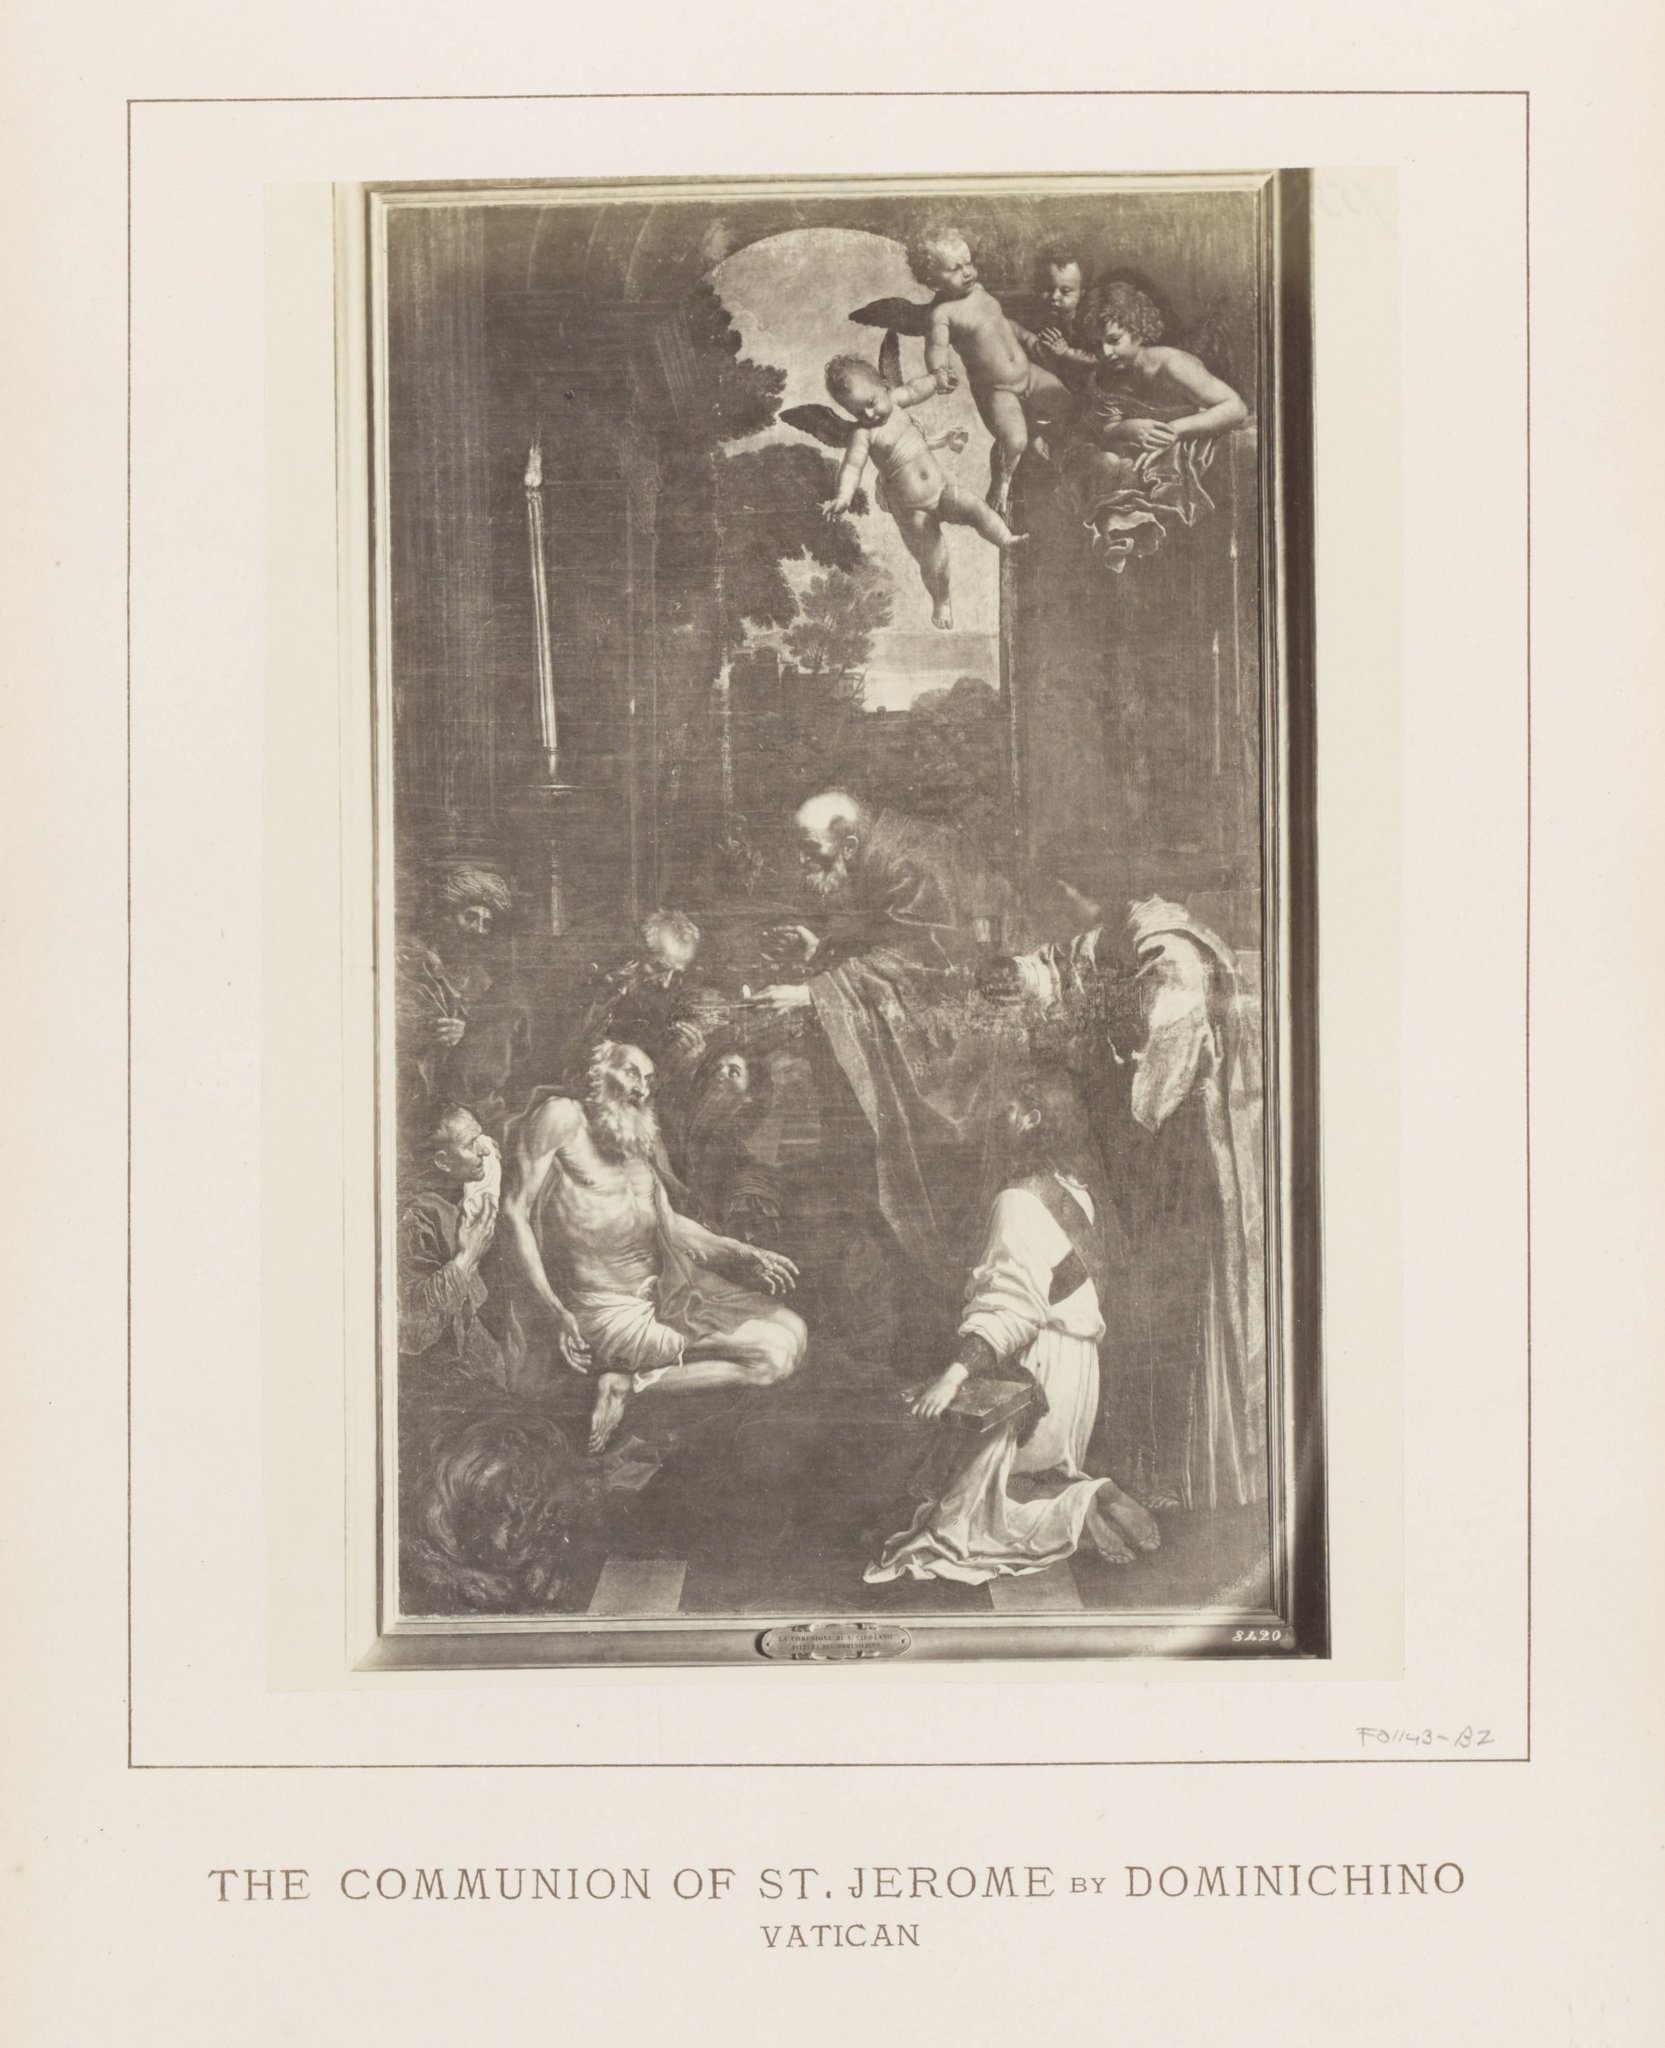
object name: reproduction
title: The communion of St. Jerome by Domenichino, Vatican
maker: Anonymous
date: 1860-1900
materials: photographic support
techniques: albumen print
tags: the last communion of st. jerome: he is attended and supported by younger priests, one of whom is about to administer the sacrament; usually st. paula is present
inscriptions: number: ‘8420’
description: Onderdeel van Fotoalbum met opnames van bezienswaardigheden en kunstwerken in Rome.